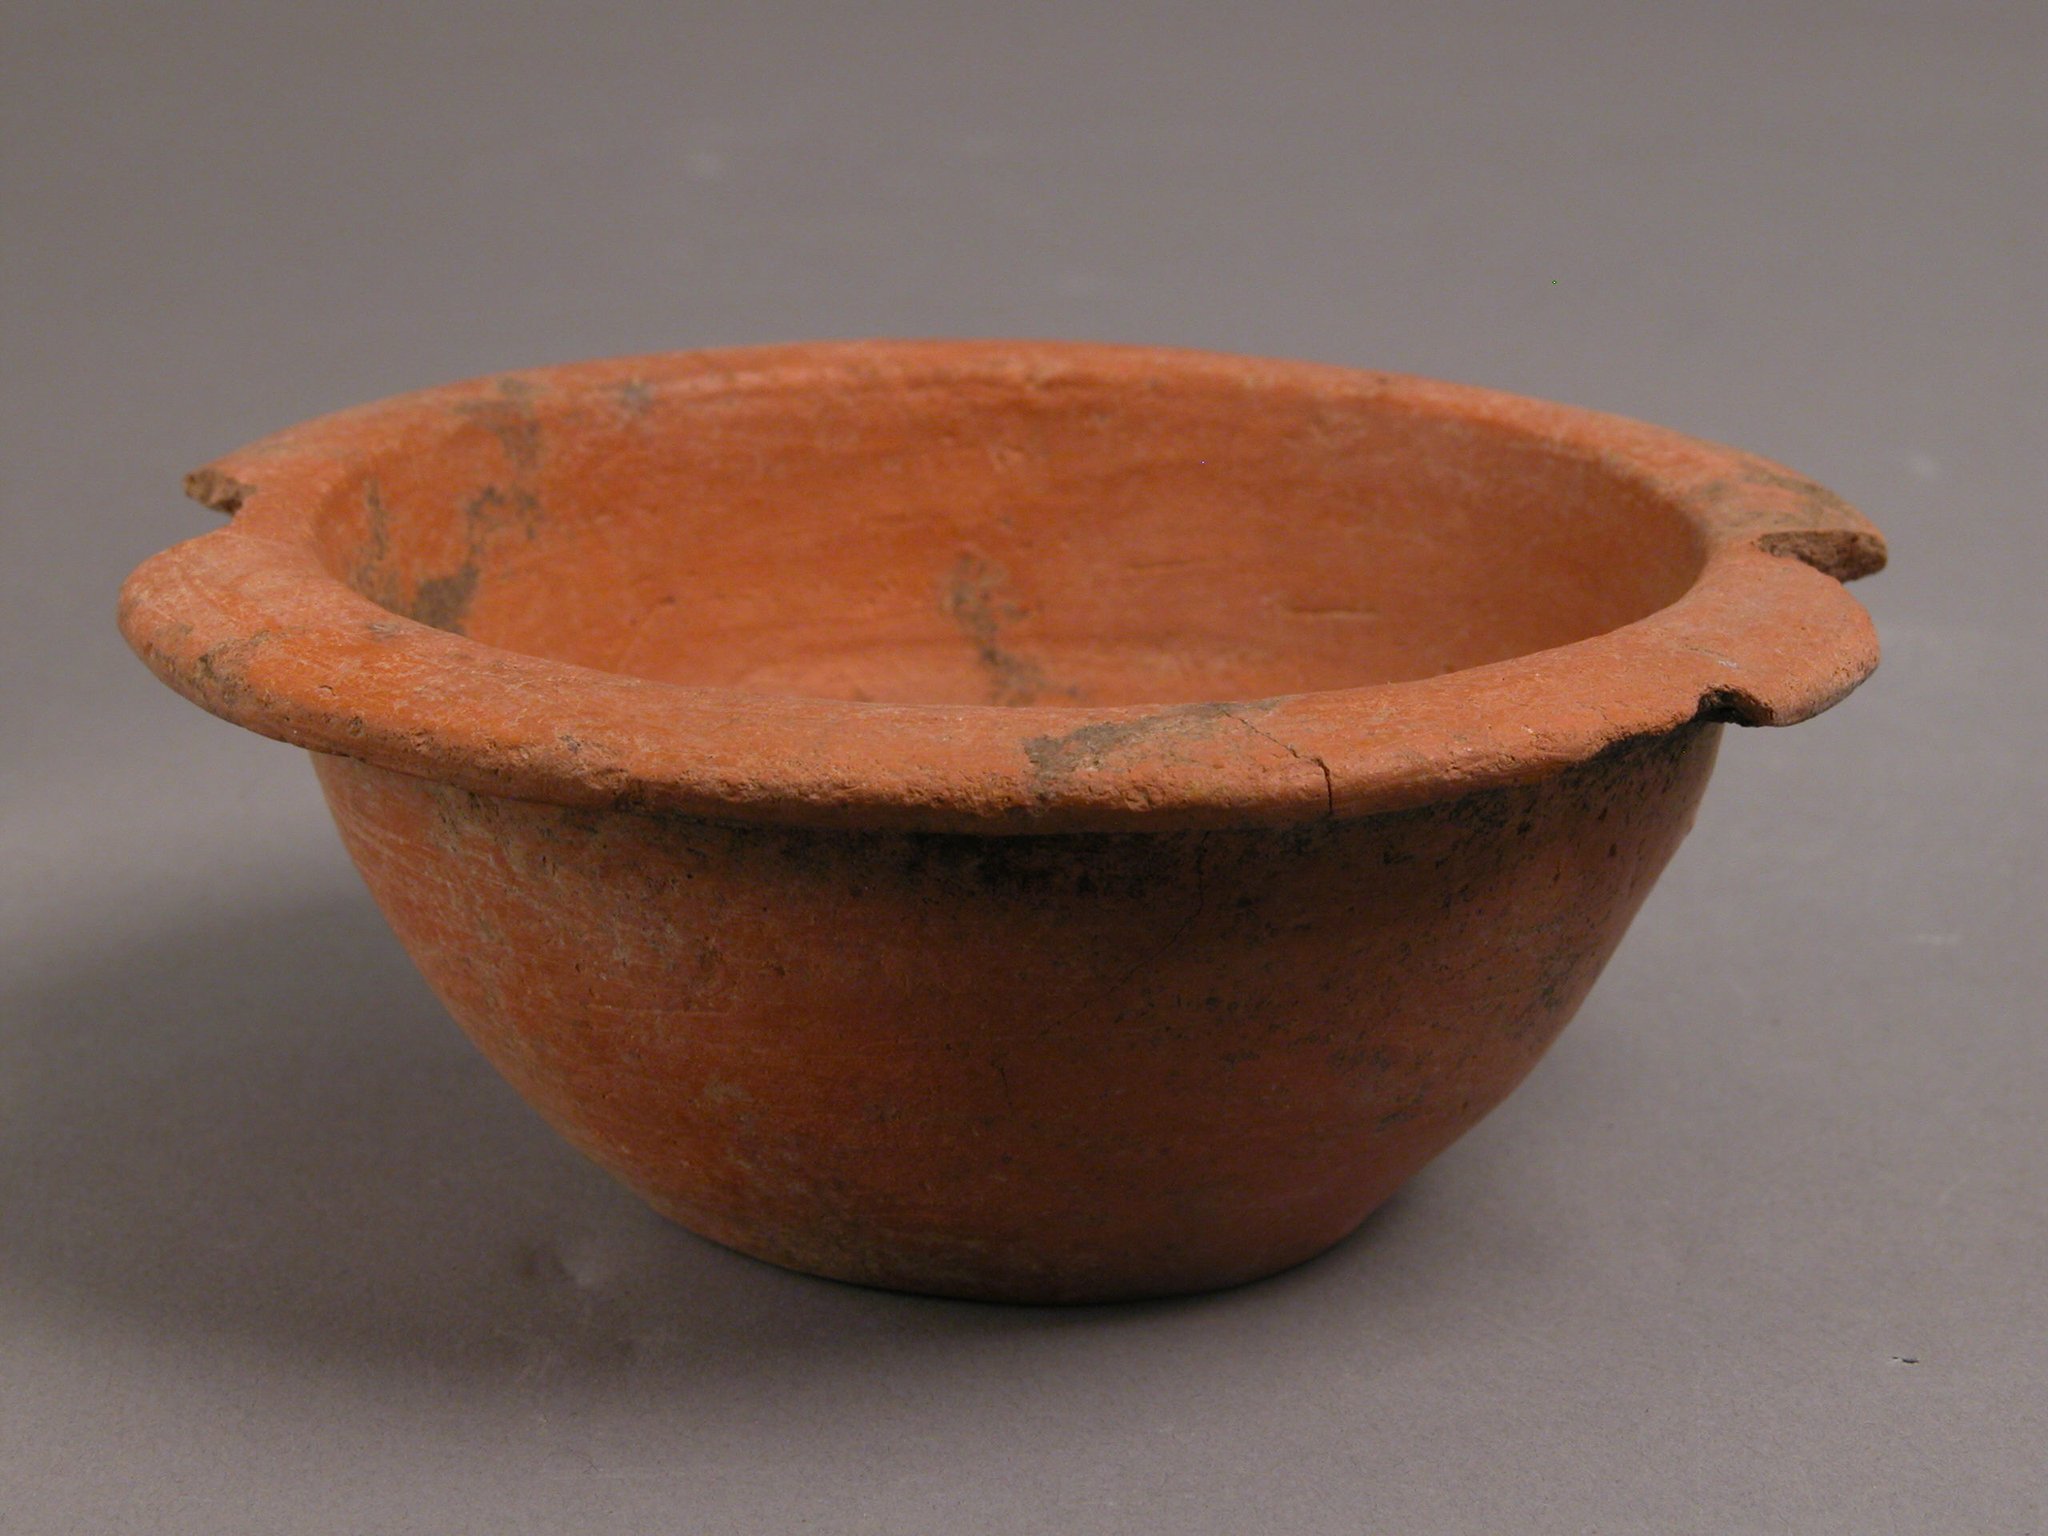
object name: bowl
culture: coptic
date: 301-700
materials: earthenware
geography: egypt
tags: bowls